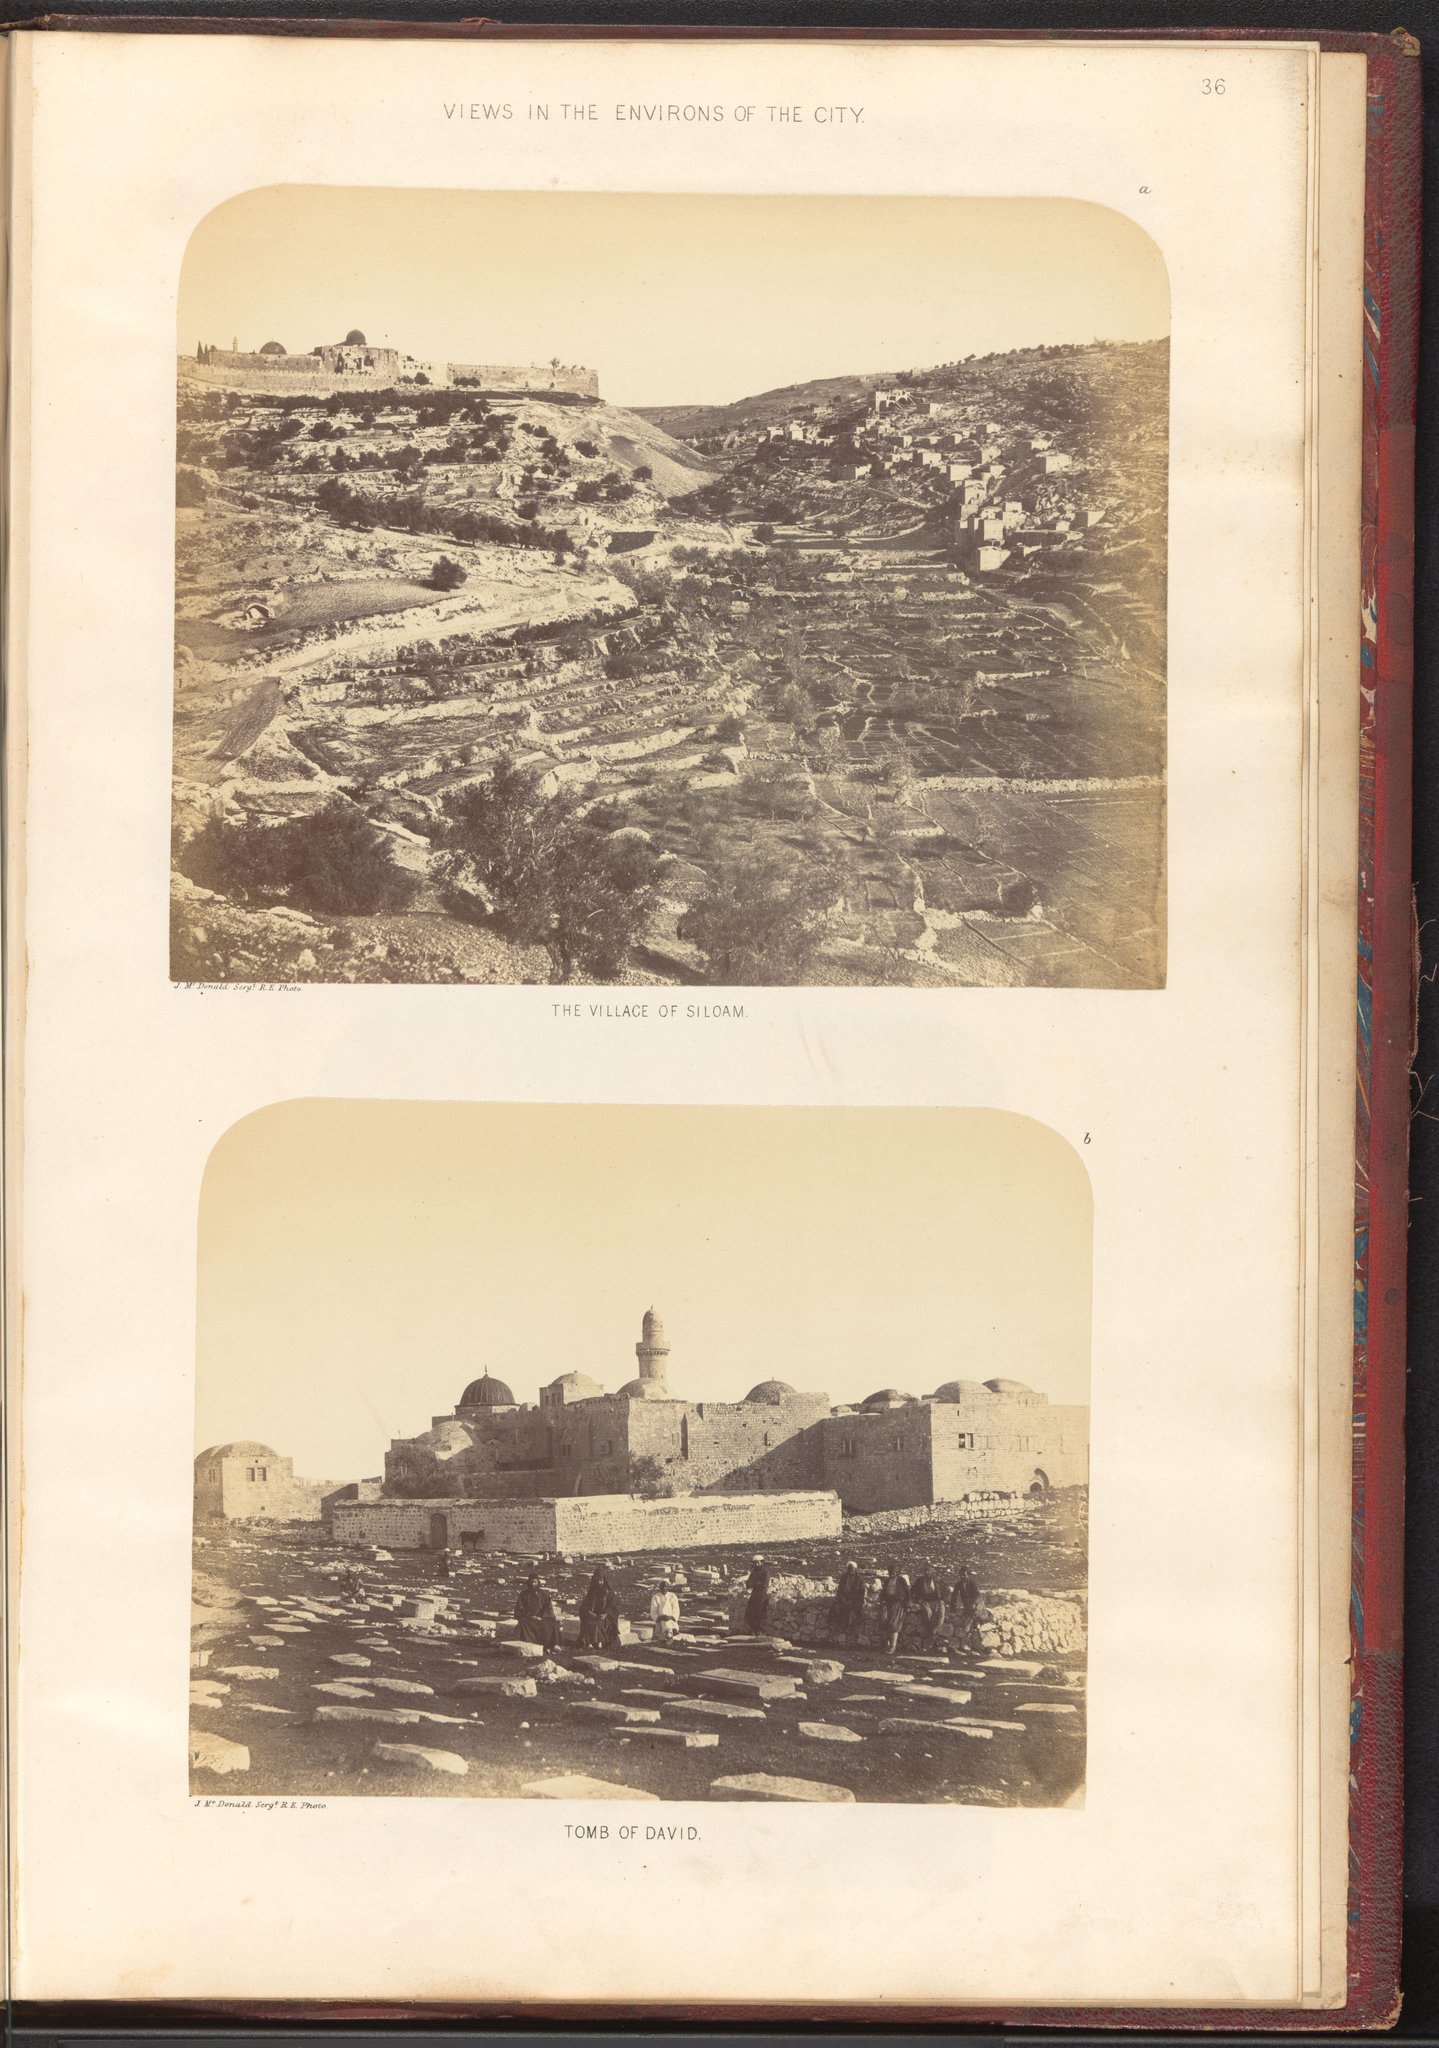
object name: page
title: Gezicht op Siloam en een gezicht op het graf van David in Jeruzalem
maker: james mcdonald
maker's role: fotograaf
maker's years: 1822-1885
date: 1860-1865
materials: paper, photographic support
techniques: albumen print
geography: jerusalem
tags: prospect of village, silhouette of village, grave, tomb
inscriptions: inscription: ‘b’, inscription: ‘a’